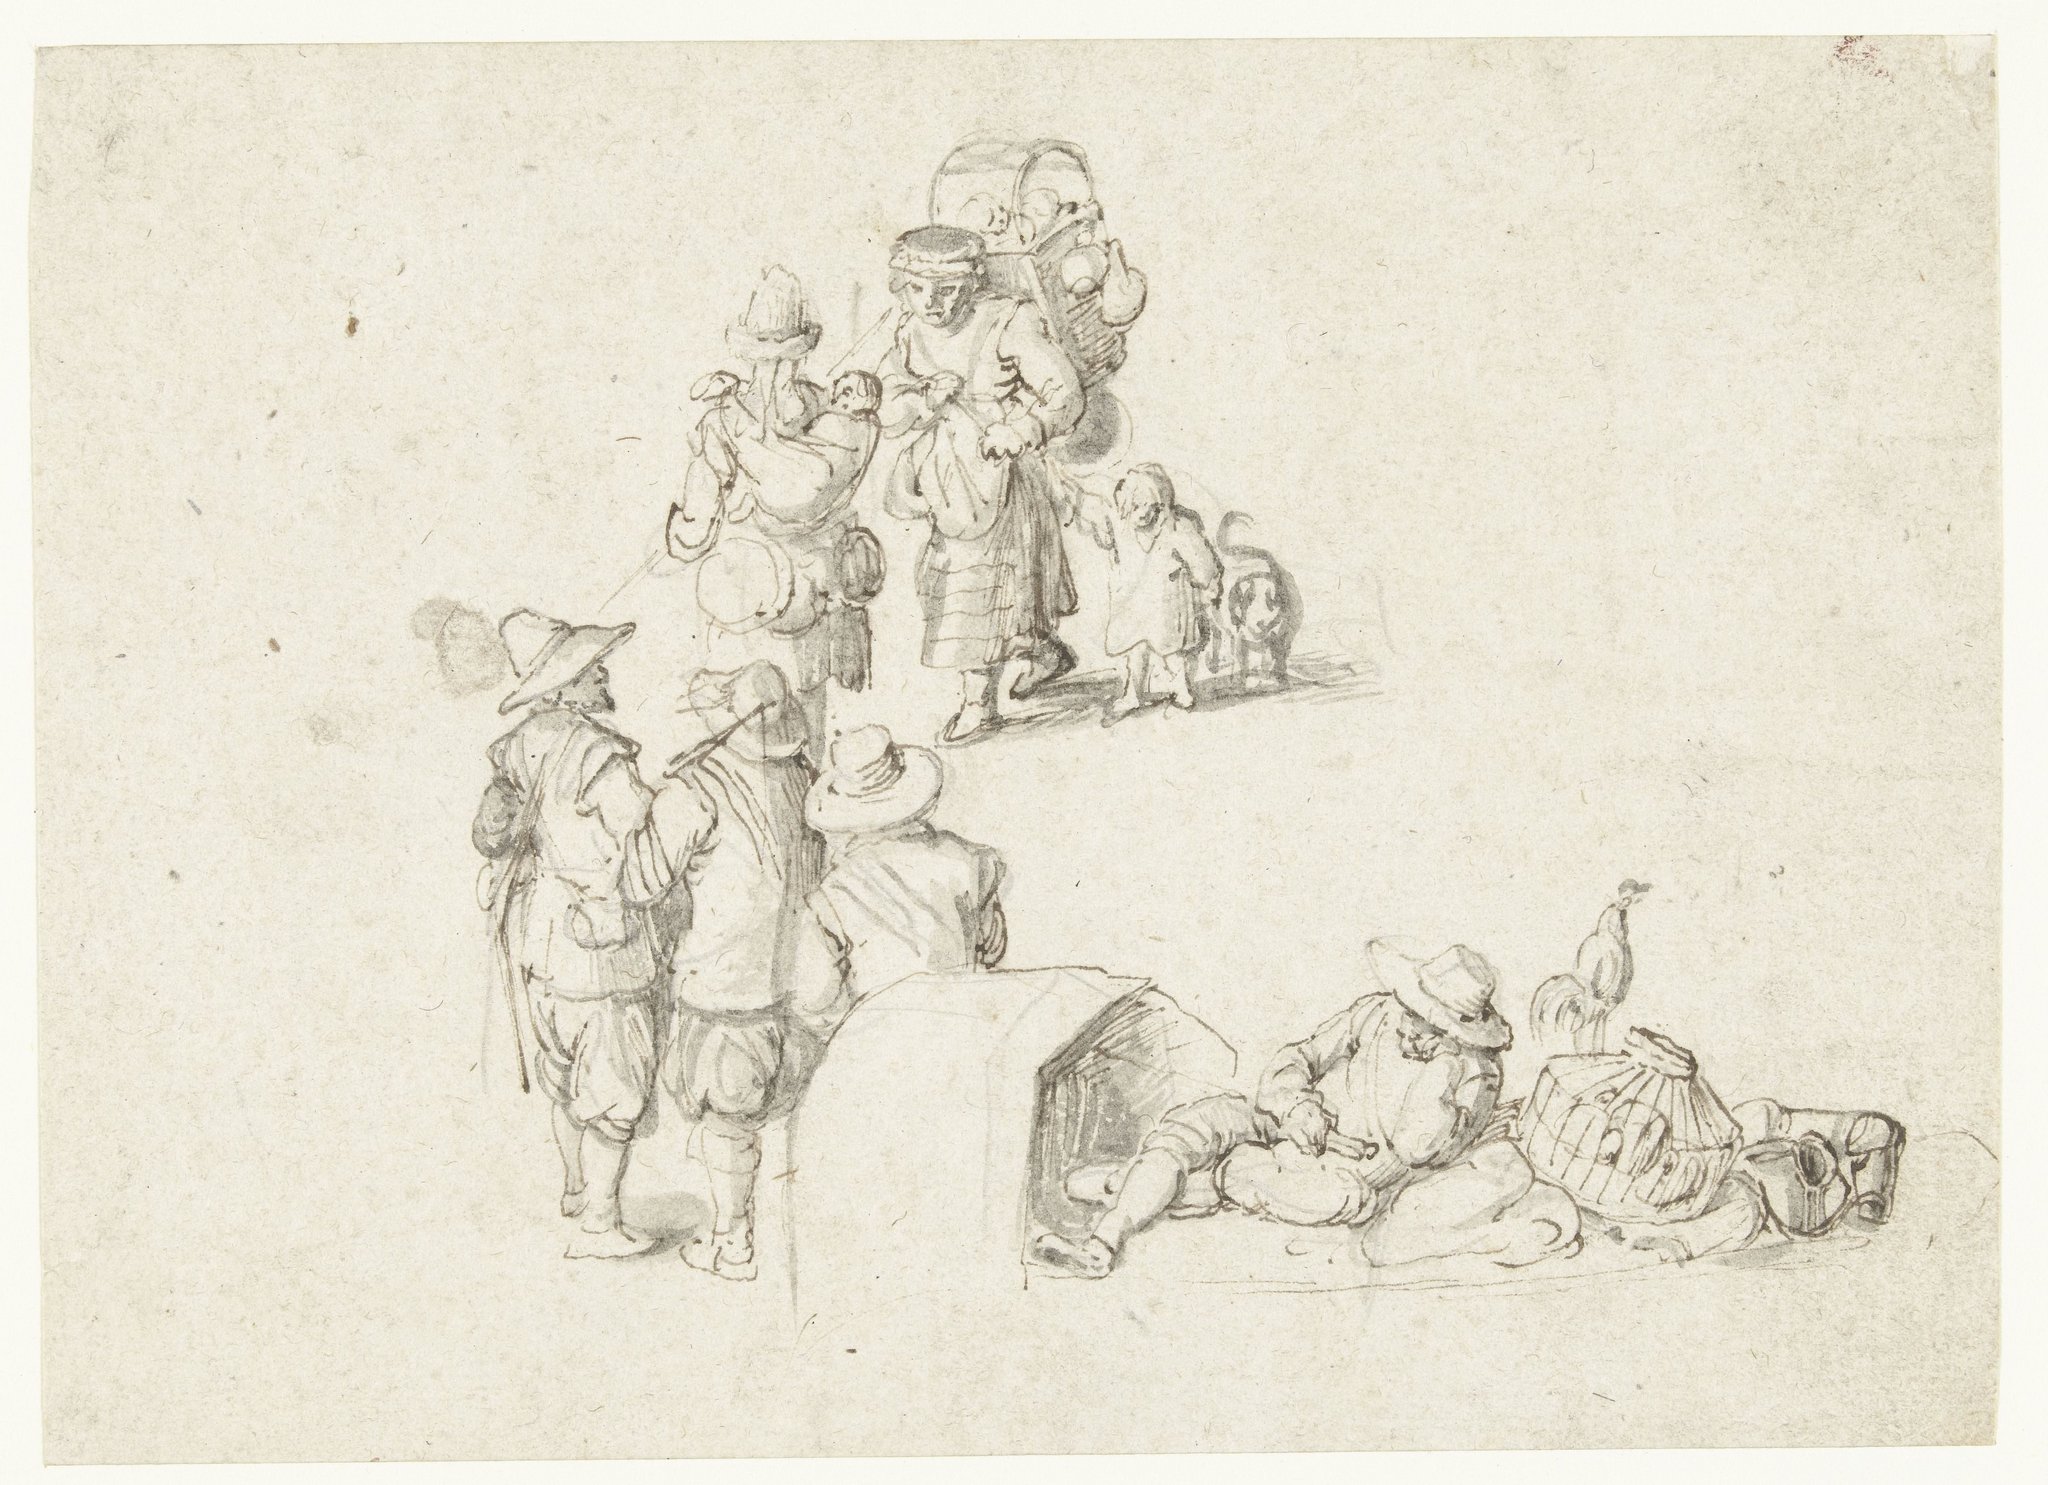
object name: drawing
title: Schetsblad met figuren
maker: Anonymous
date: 1600-1700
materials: ink, paper, pencil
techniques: brush, pen